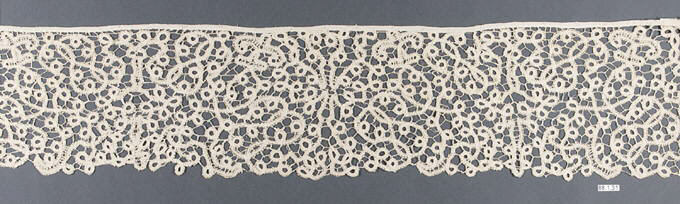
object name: fragment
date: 1601-1700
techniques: lace